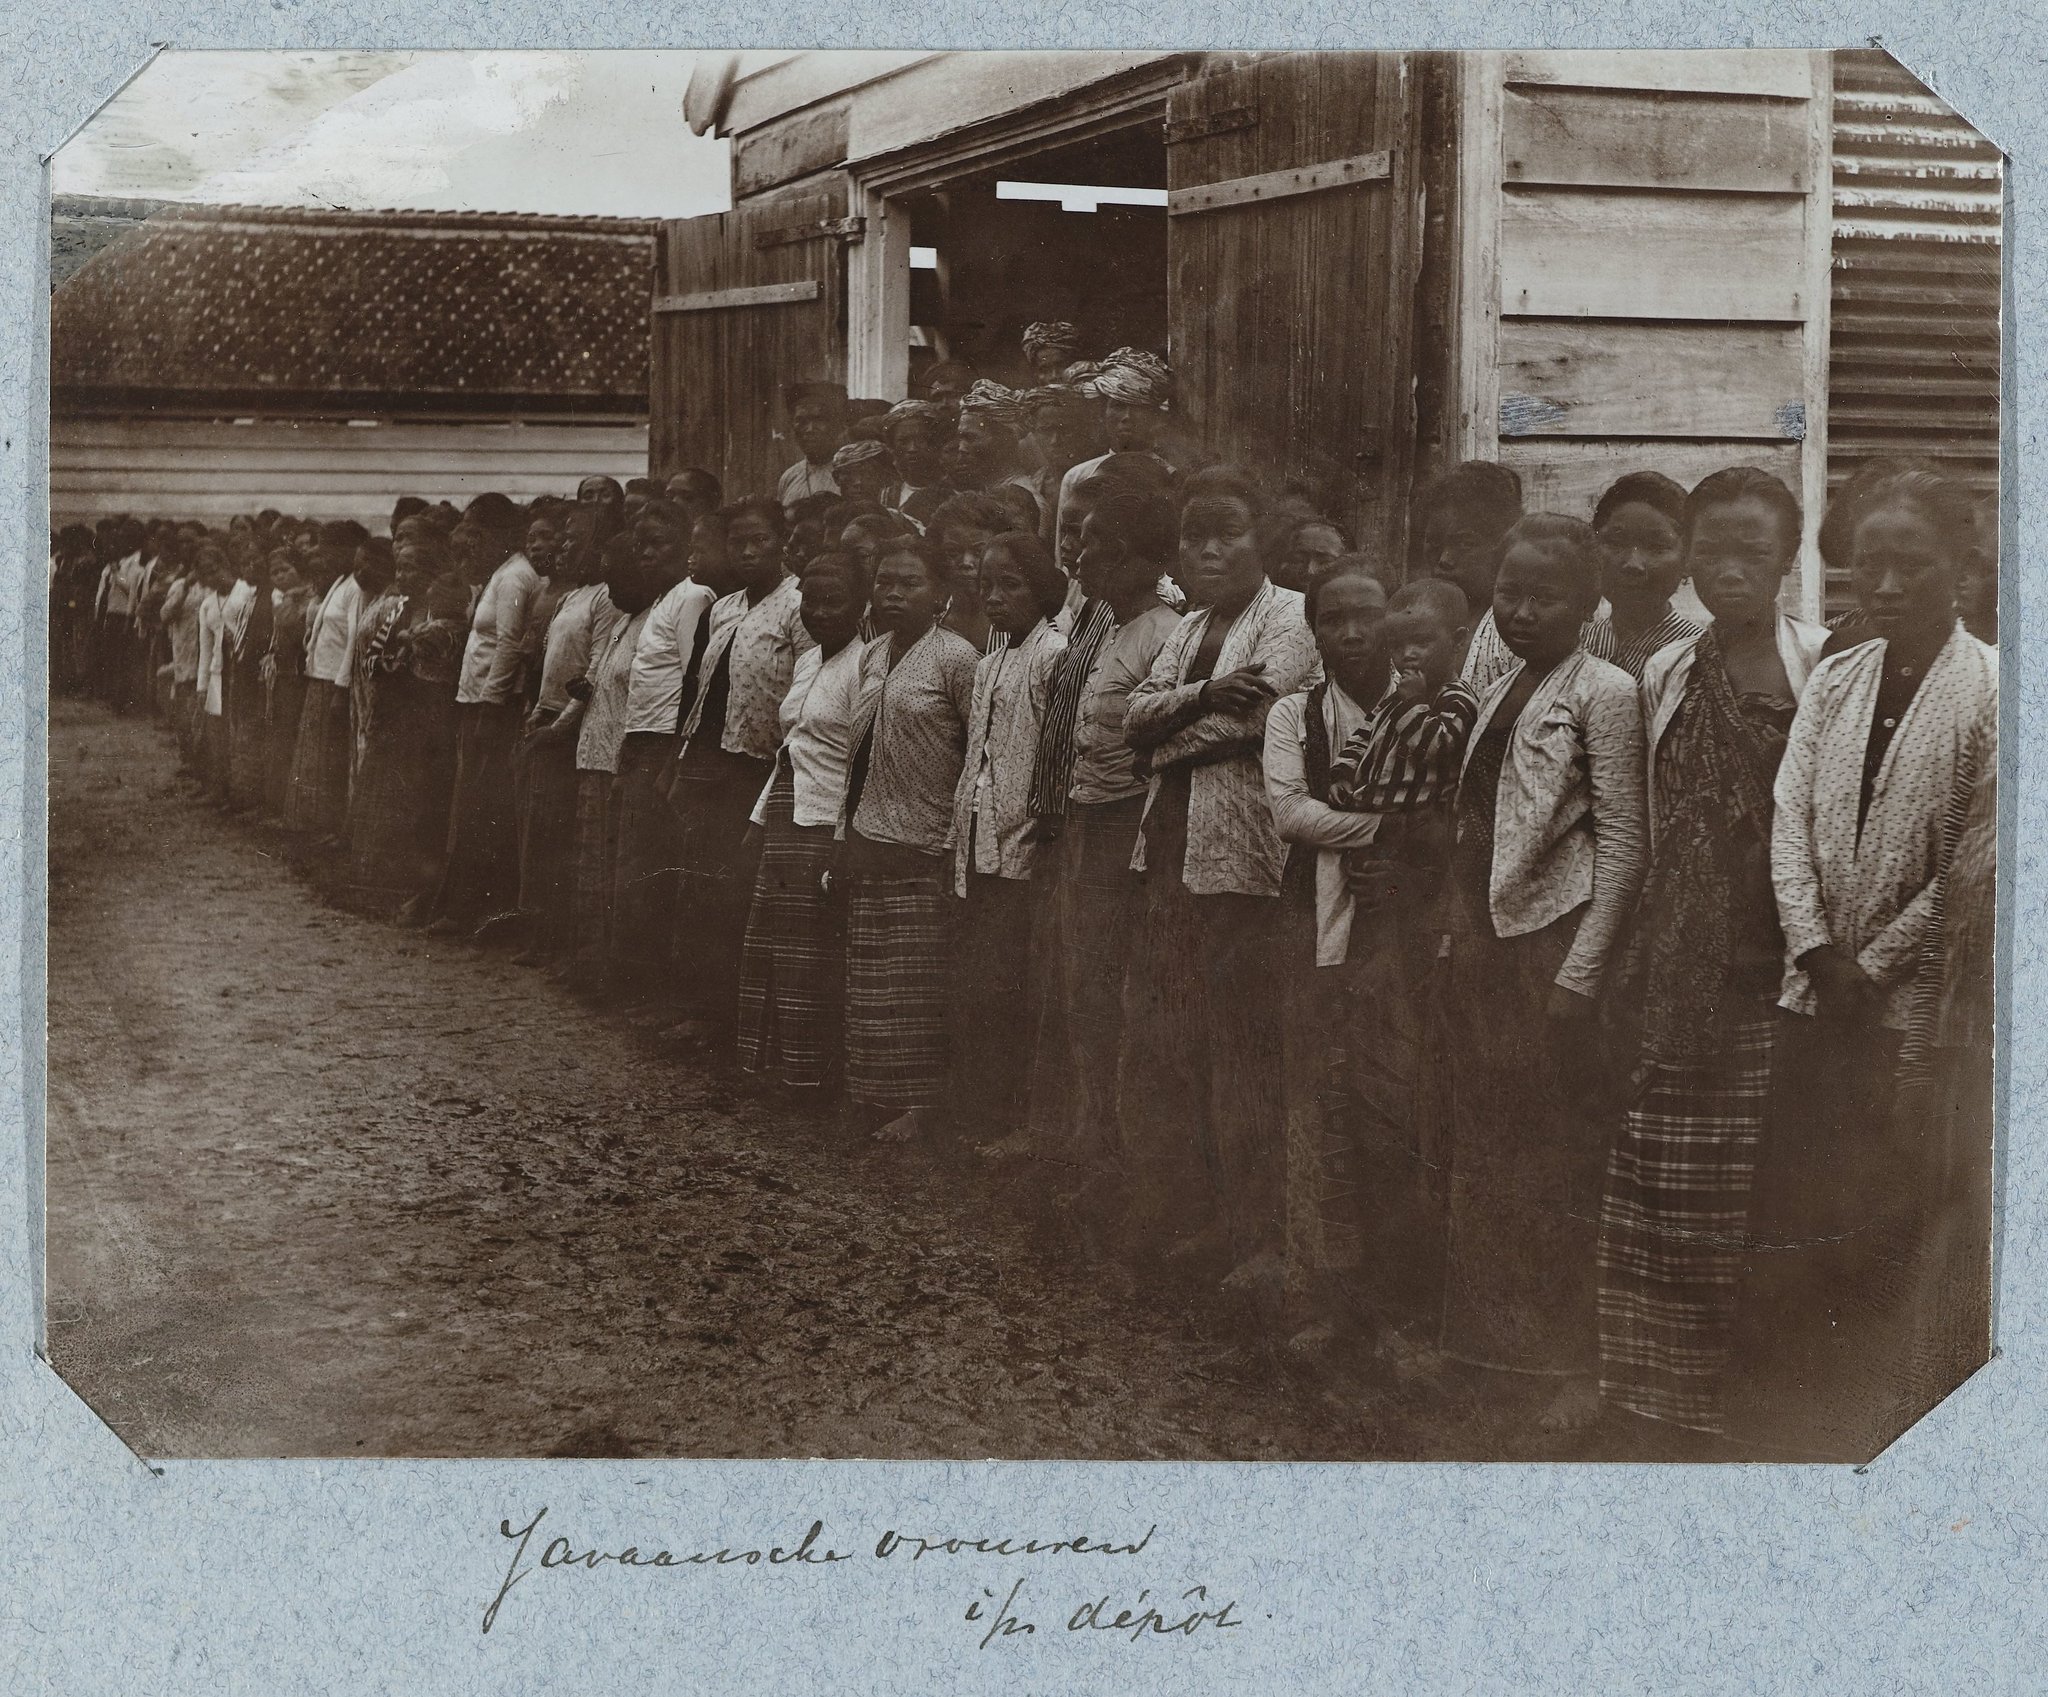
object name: photograph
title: Javaanse vrouwen in het immigrantendepot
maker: théodore van lelyveld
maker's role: painter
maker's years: 1867-1954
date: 1895-1898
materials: photographic support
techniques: collodion silver print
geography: suriname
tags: migrants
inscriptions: inscription: ‘Javaansche vrouwen i/h dépôt’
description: Javaanse vrouwen opgesteld in een rij in het immigrantendepot of zgn. ‘koeliedepot’, het centrale meldpunt voor immigranten in te Paramaribo. Fotoafdruk in een fotoalbum van Théodore van Lelyveld over Suriname uit 1895-1898.